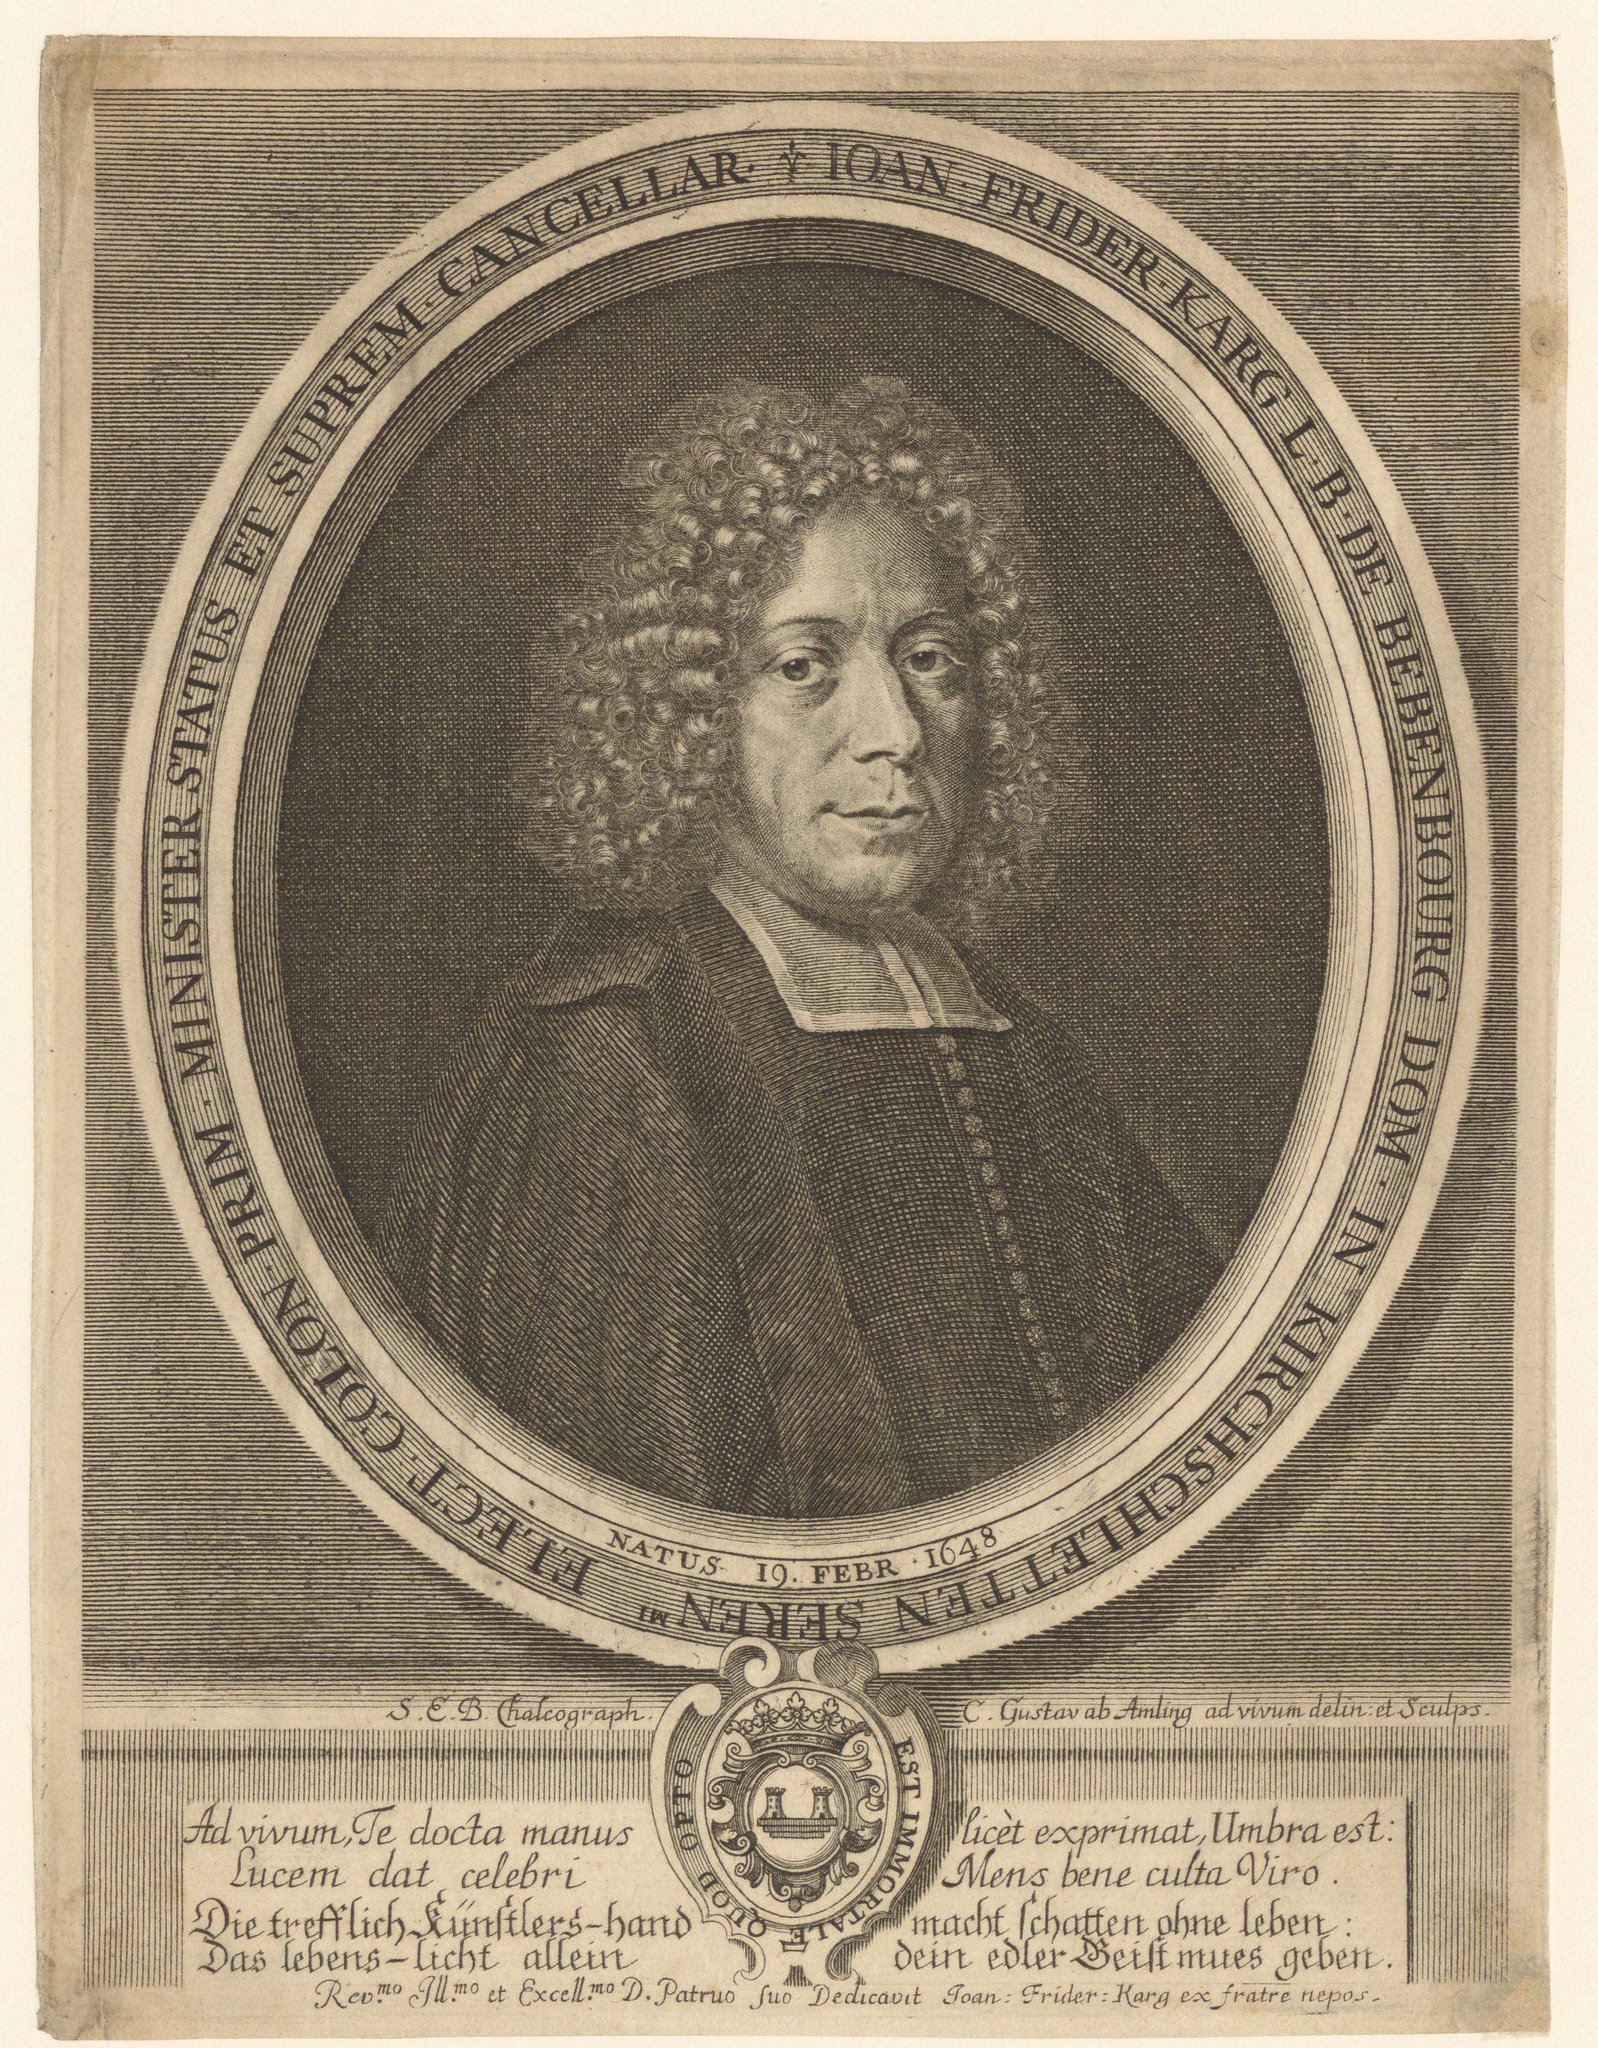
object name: print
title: Portret van Johann Friedrich Karg von Bebenburg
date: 1688-1702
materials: paper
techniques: engraving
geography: munich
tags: johann friedrich reichsfreiherr karg von bebenburg, historical persons, armorial bearing, heraldry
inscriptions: collector's mark: Lugt 2228, watermark